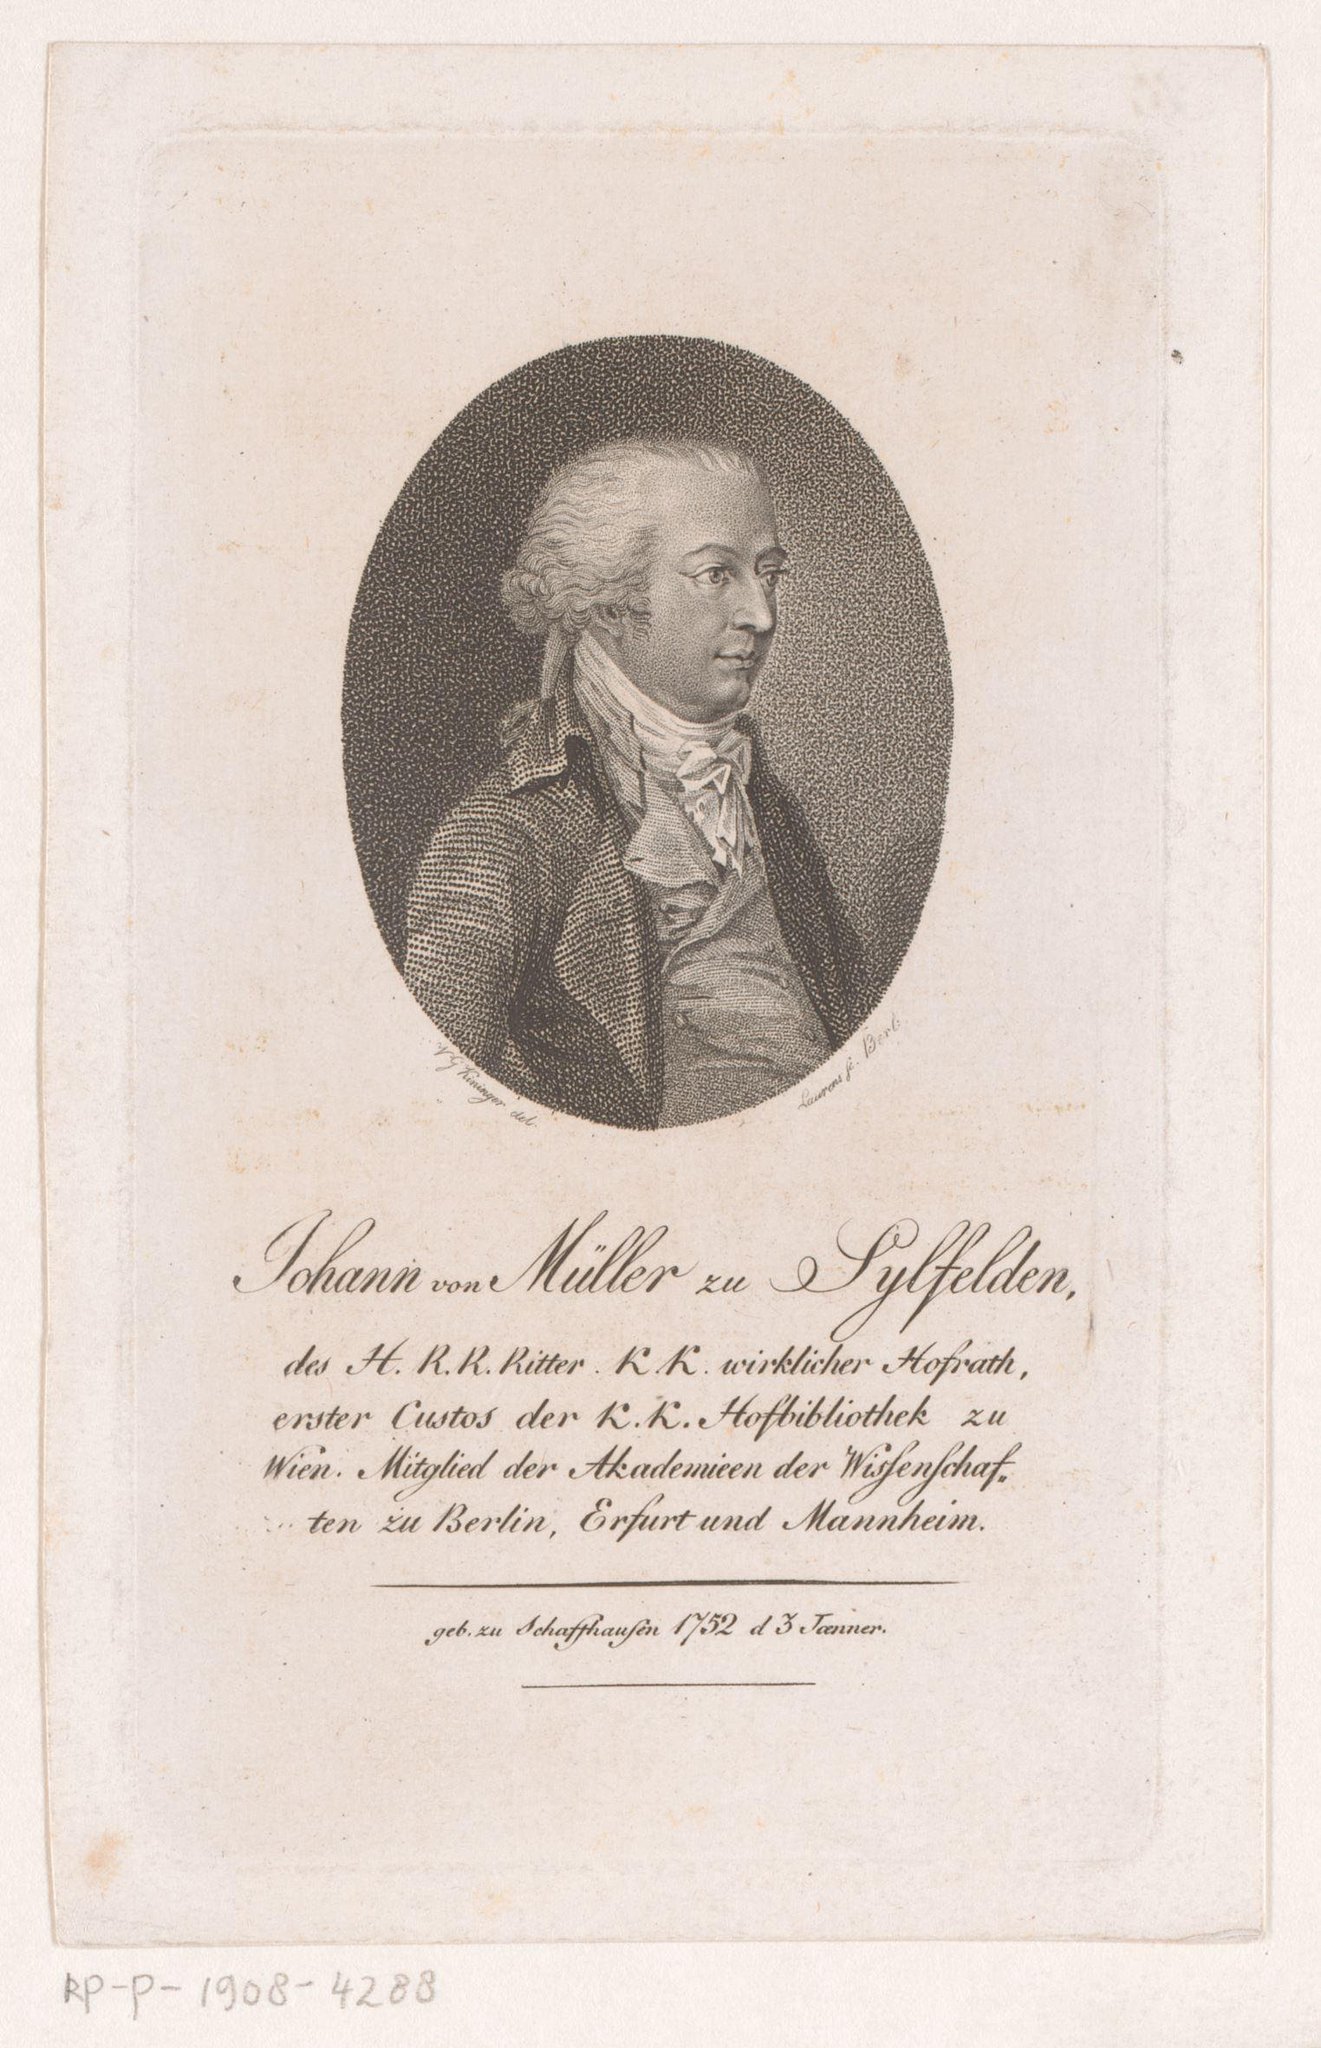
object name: print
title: Portret van Johannes Müller von Sylvelden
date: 1791-1832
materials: paper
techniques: stippling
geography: berlin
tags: further education (+ portrait of teacher, professor), historical persons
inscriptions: collector's mark: Lugt 2228